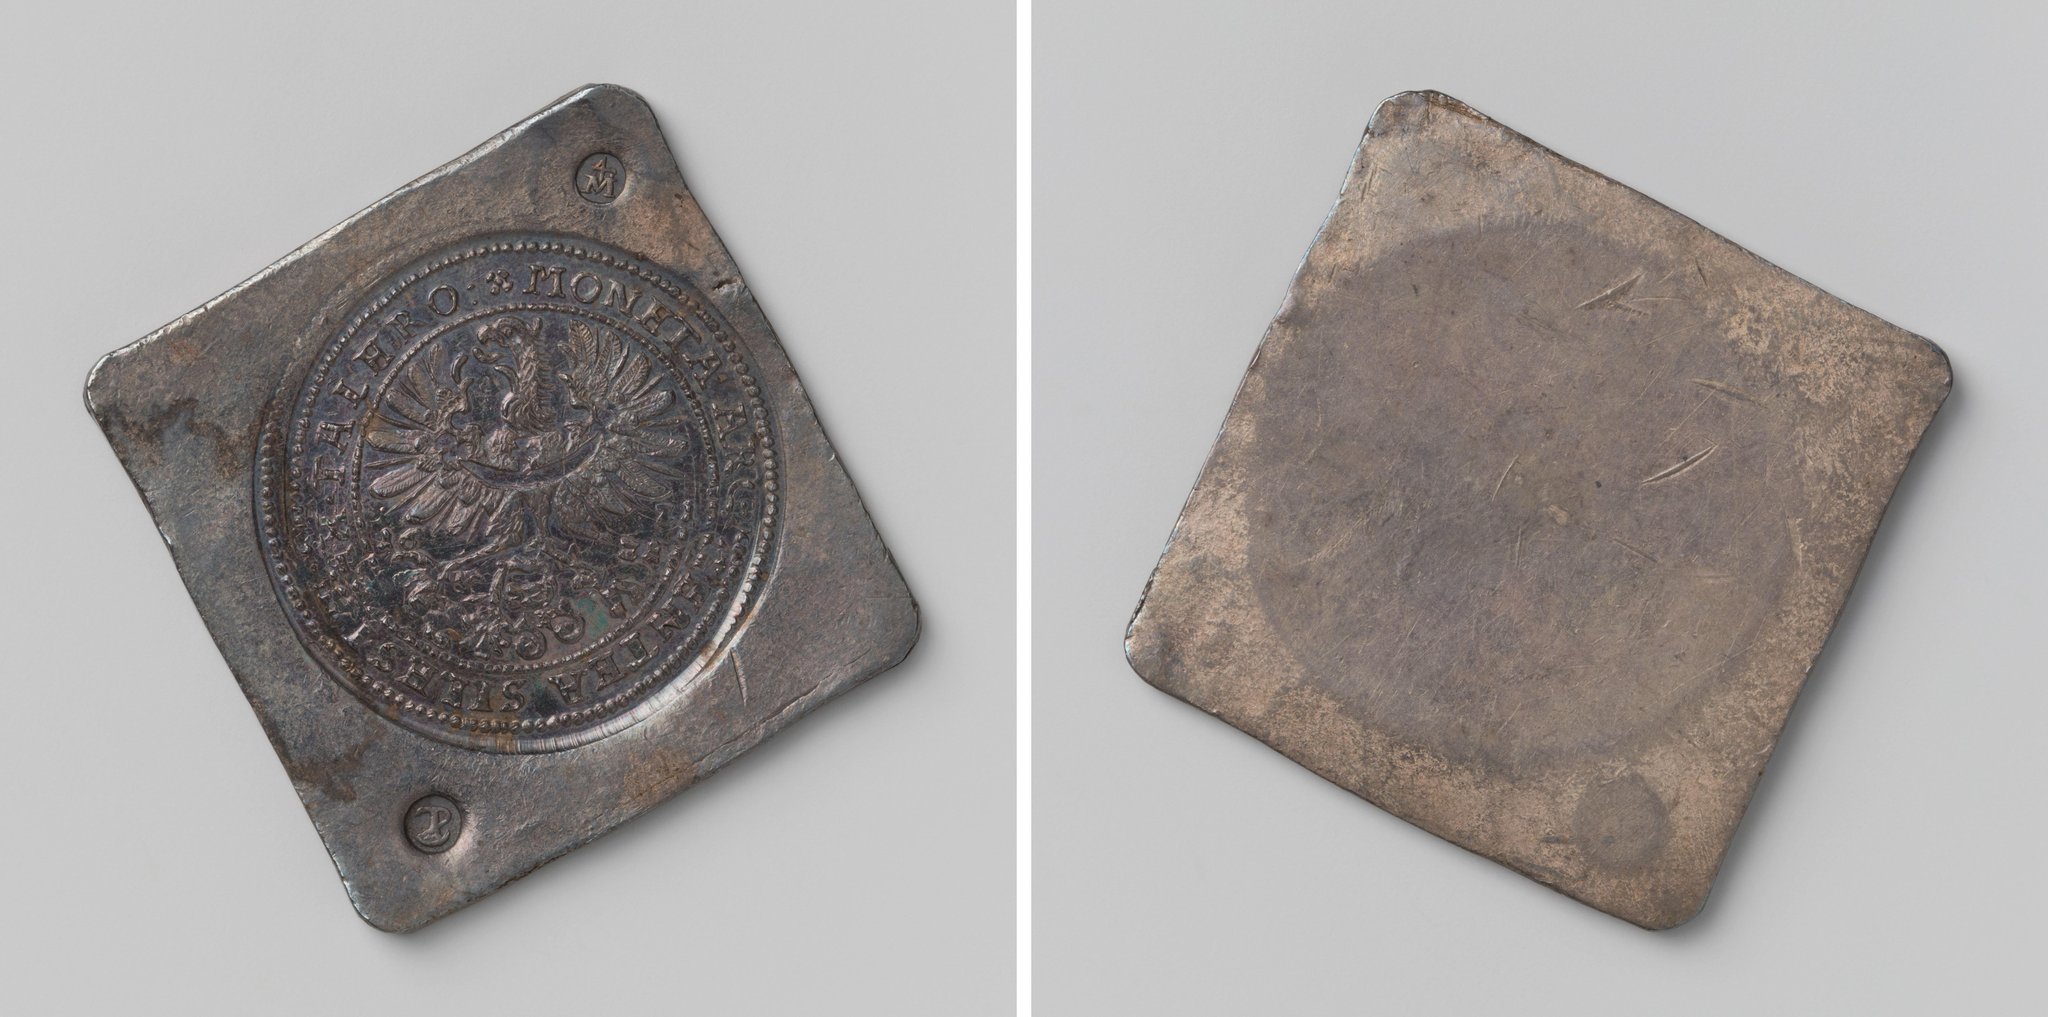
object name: siege coin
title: Zes taler, noodmunt geslagen door de verbonden prinsen van Silezië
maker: Anonymous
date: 1621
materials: silver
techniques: striking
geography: głogów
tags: silezië, dertigjarige oorlog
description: eenzijdige, ruitvormige noodmunt met afgeronde hoeken. Voorzijde: drie stempels: onder en boven: twee hismerken; midden: adelaar met gespreide vleugels en voor zich een met kruis bekroonde halve maan tussen jaartal binnen omschrift. Keerzijde: blanco